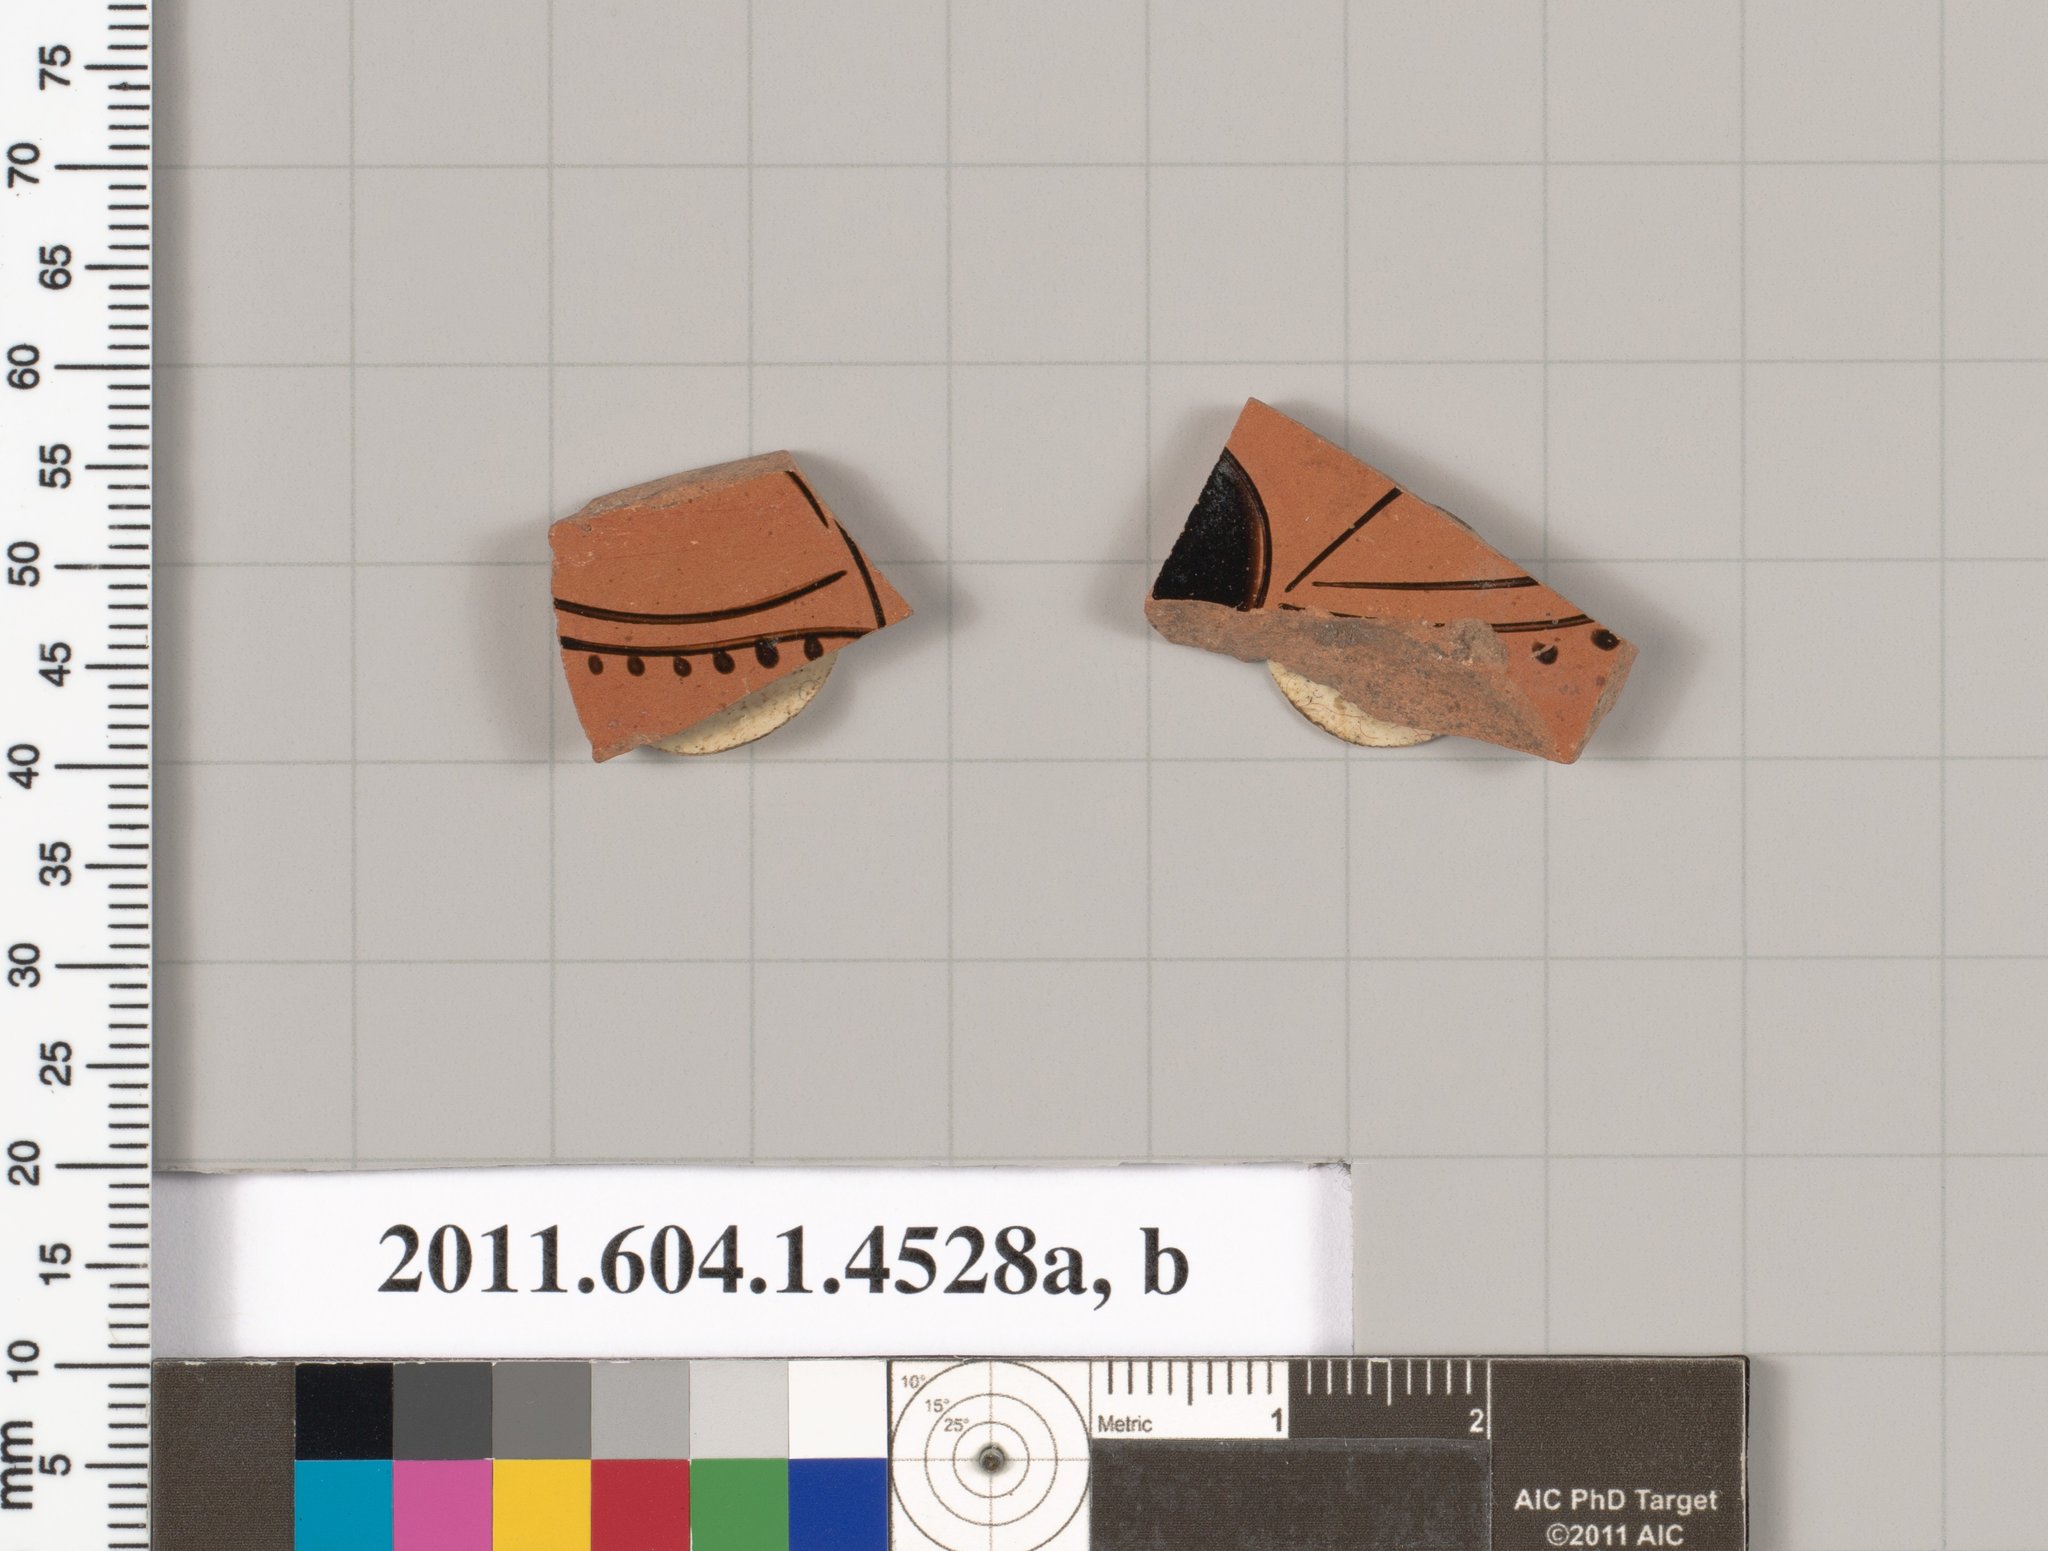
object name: kylix fragment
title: Terracotta fragments of a kylix (drinking cup)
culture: greek, attic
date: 500-480 BCE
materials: terracotta